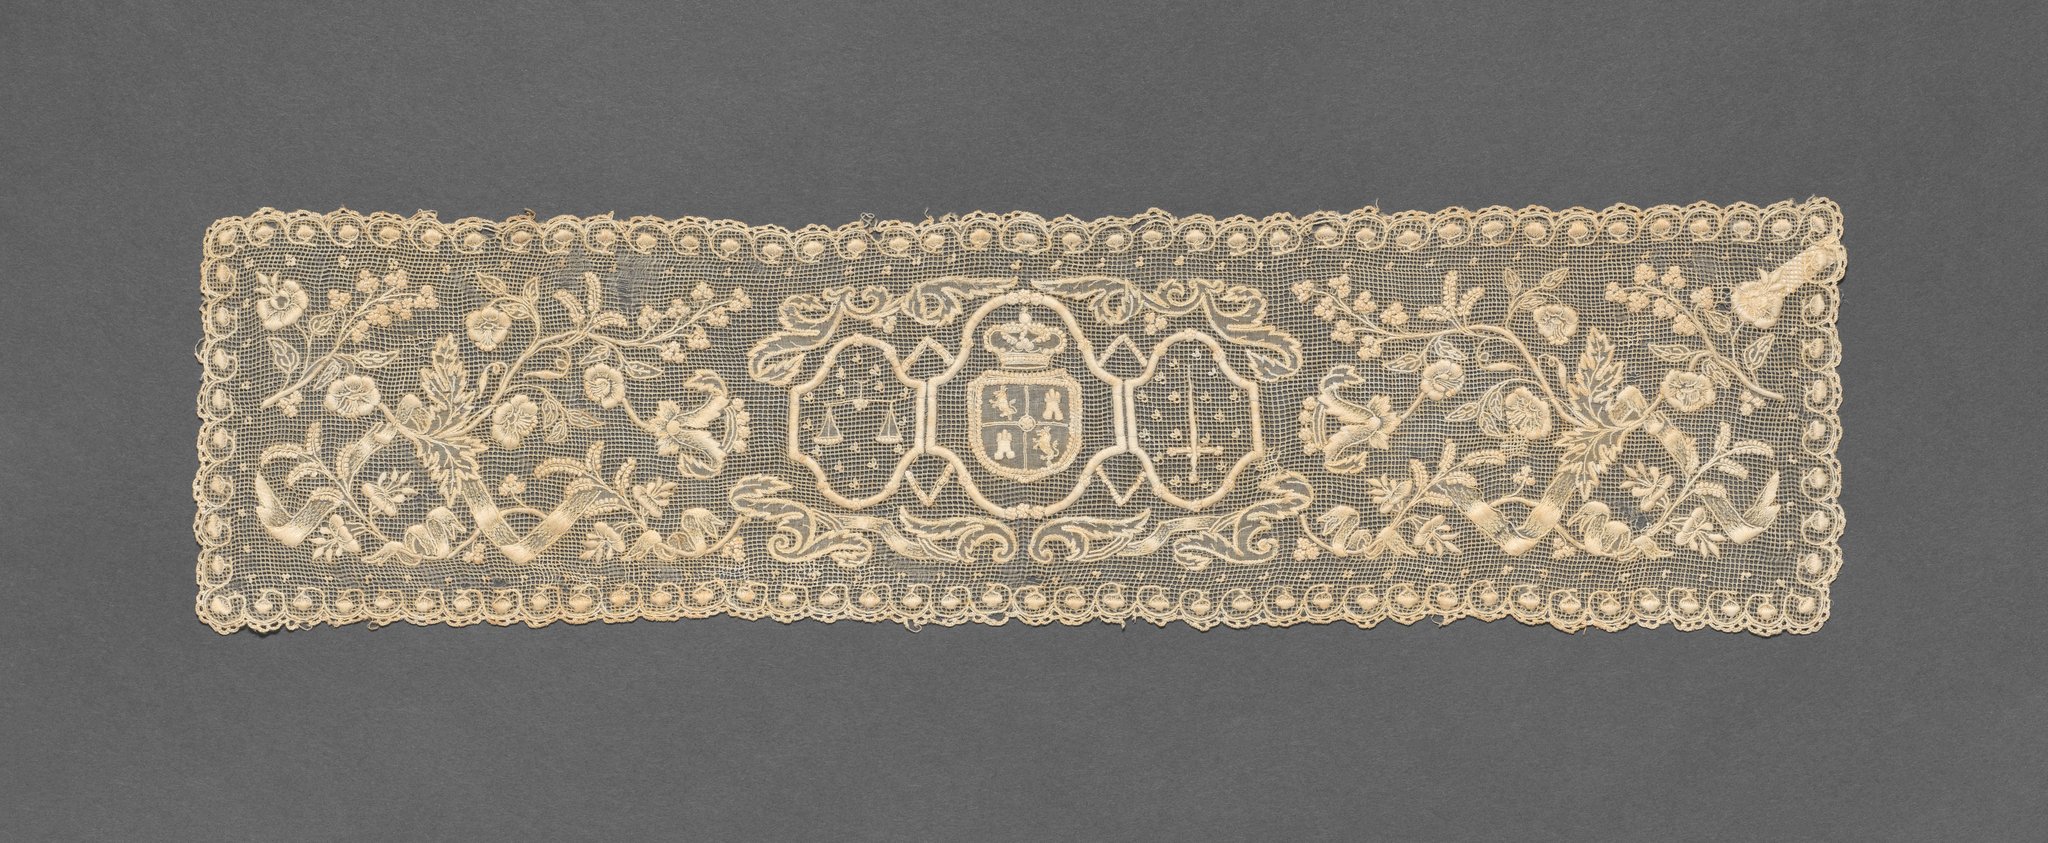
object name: sleeve piece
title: Pair of sleeve pieces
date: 1801-1833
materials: fiber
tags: coat of arms